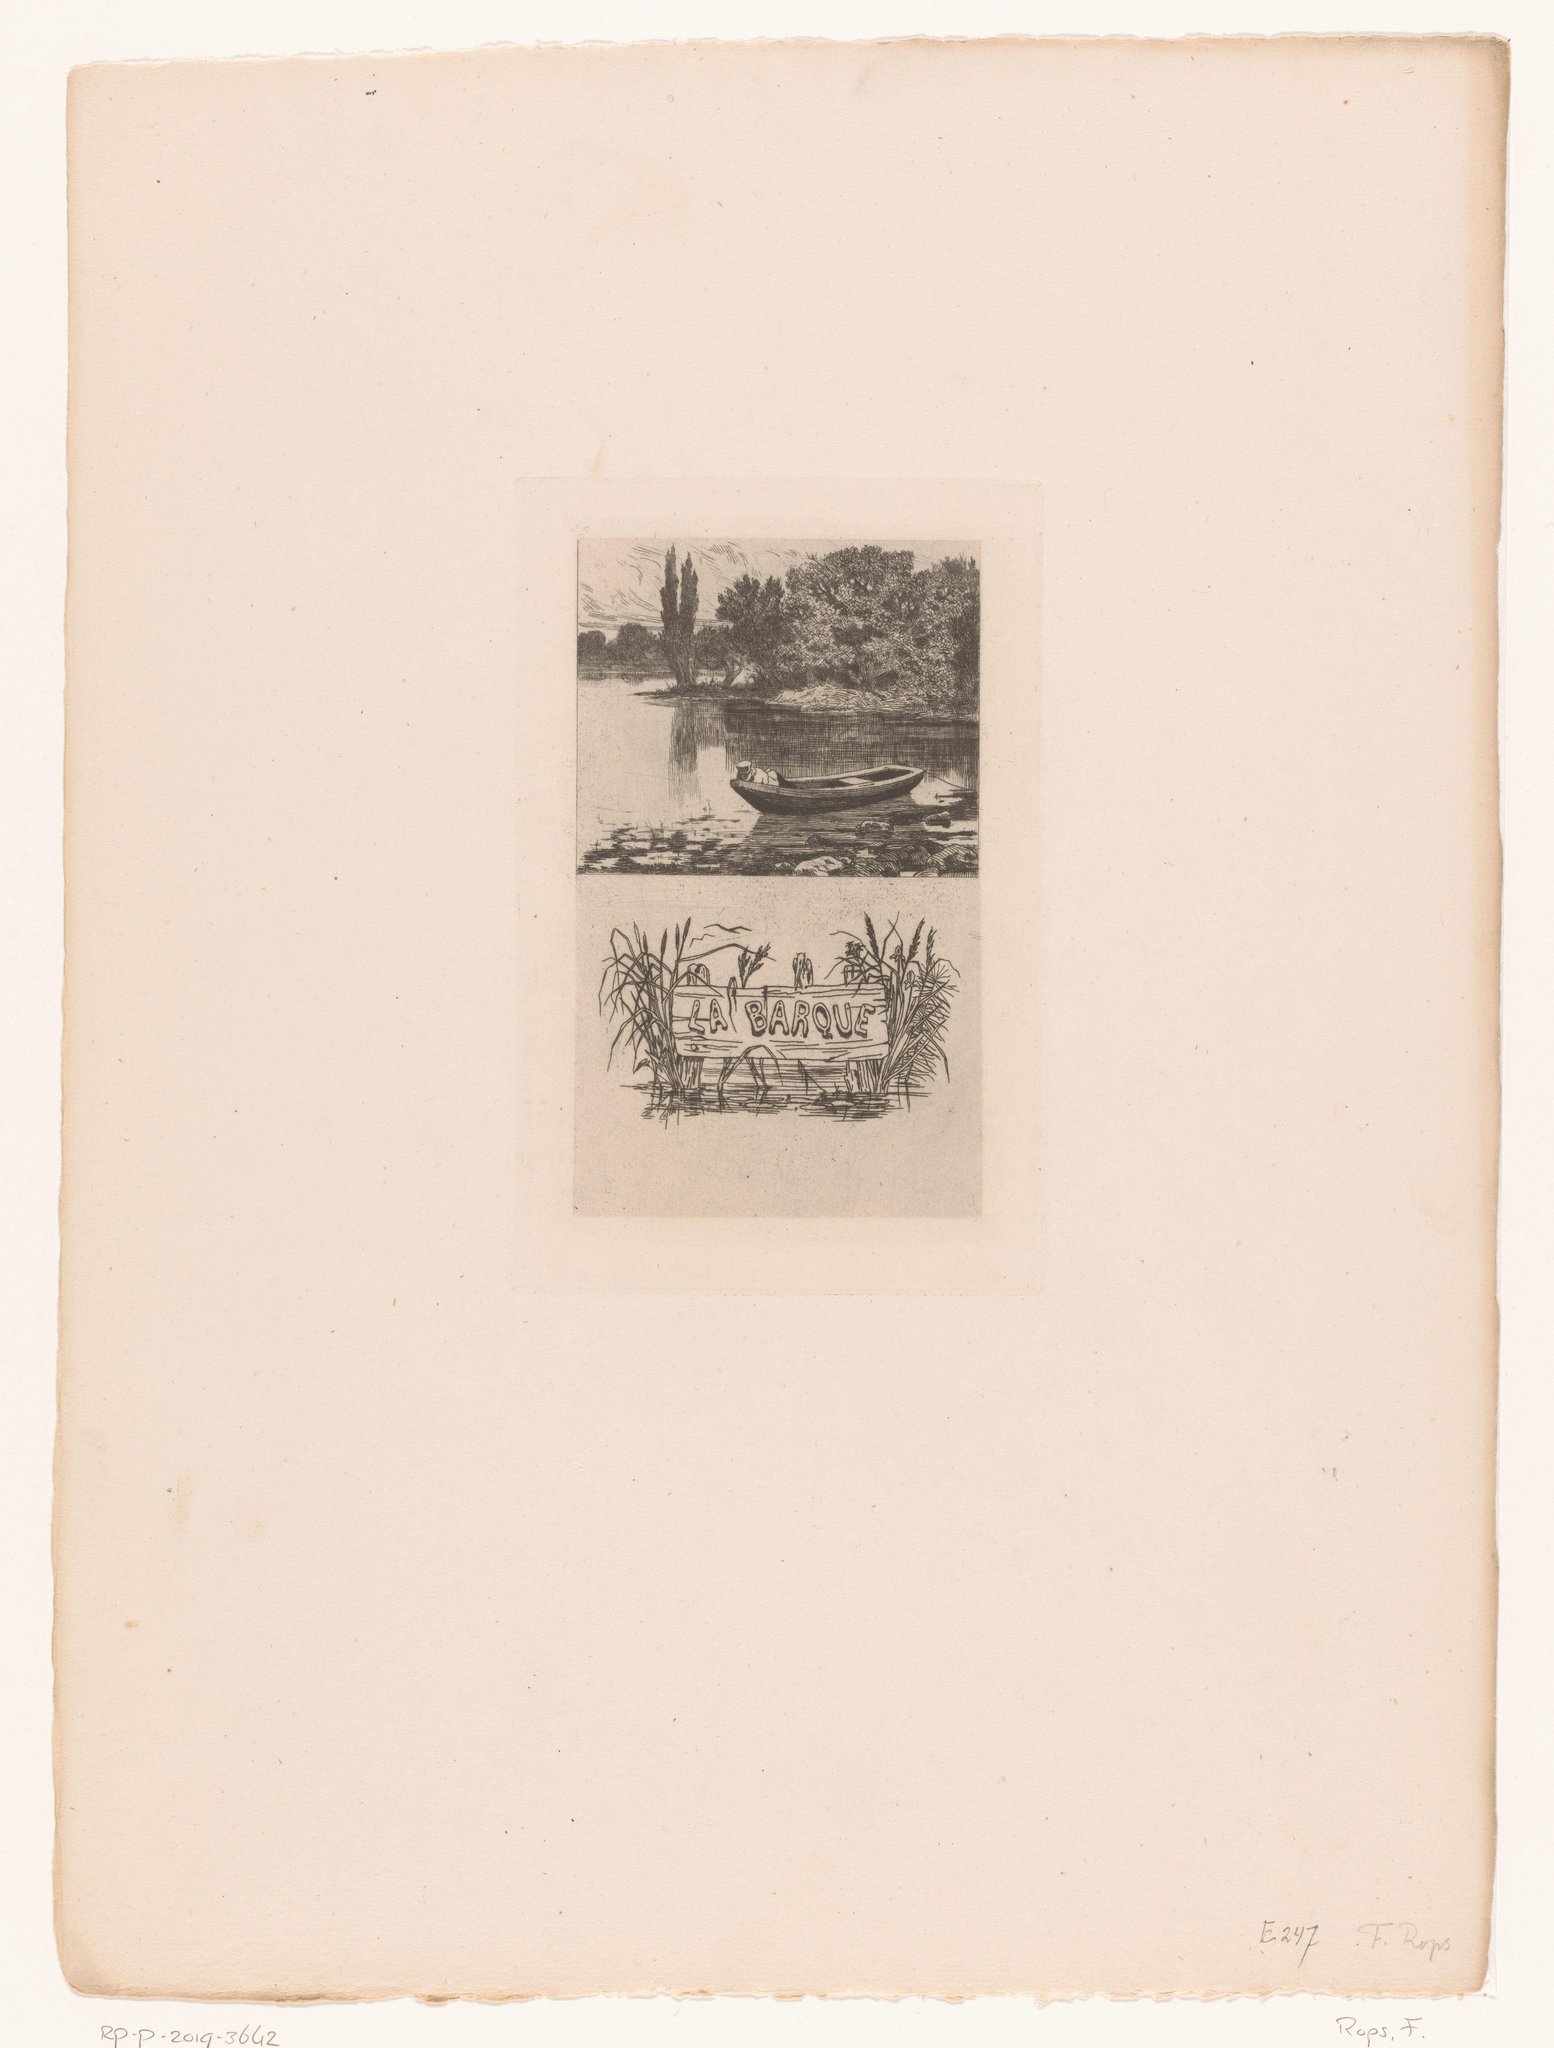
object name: print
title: La barque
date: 1875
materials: paper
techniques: aquatint, etching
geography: brussels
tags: rowing-boat, canoe, etc., lake, plants and herbs: reed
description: Prent uit: Rops, Félicien (red.), Cahier d'études eaux-fortes originales et inédites. Brussel: Felix Callewaert père, 1875.